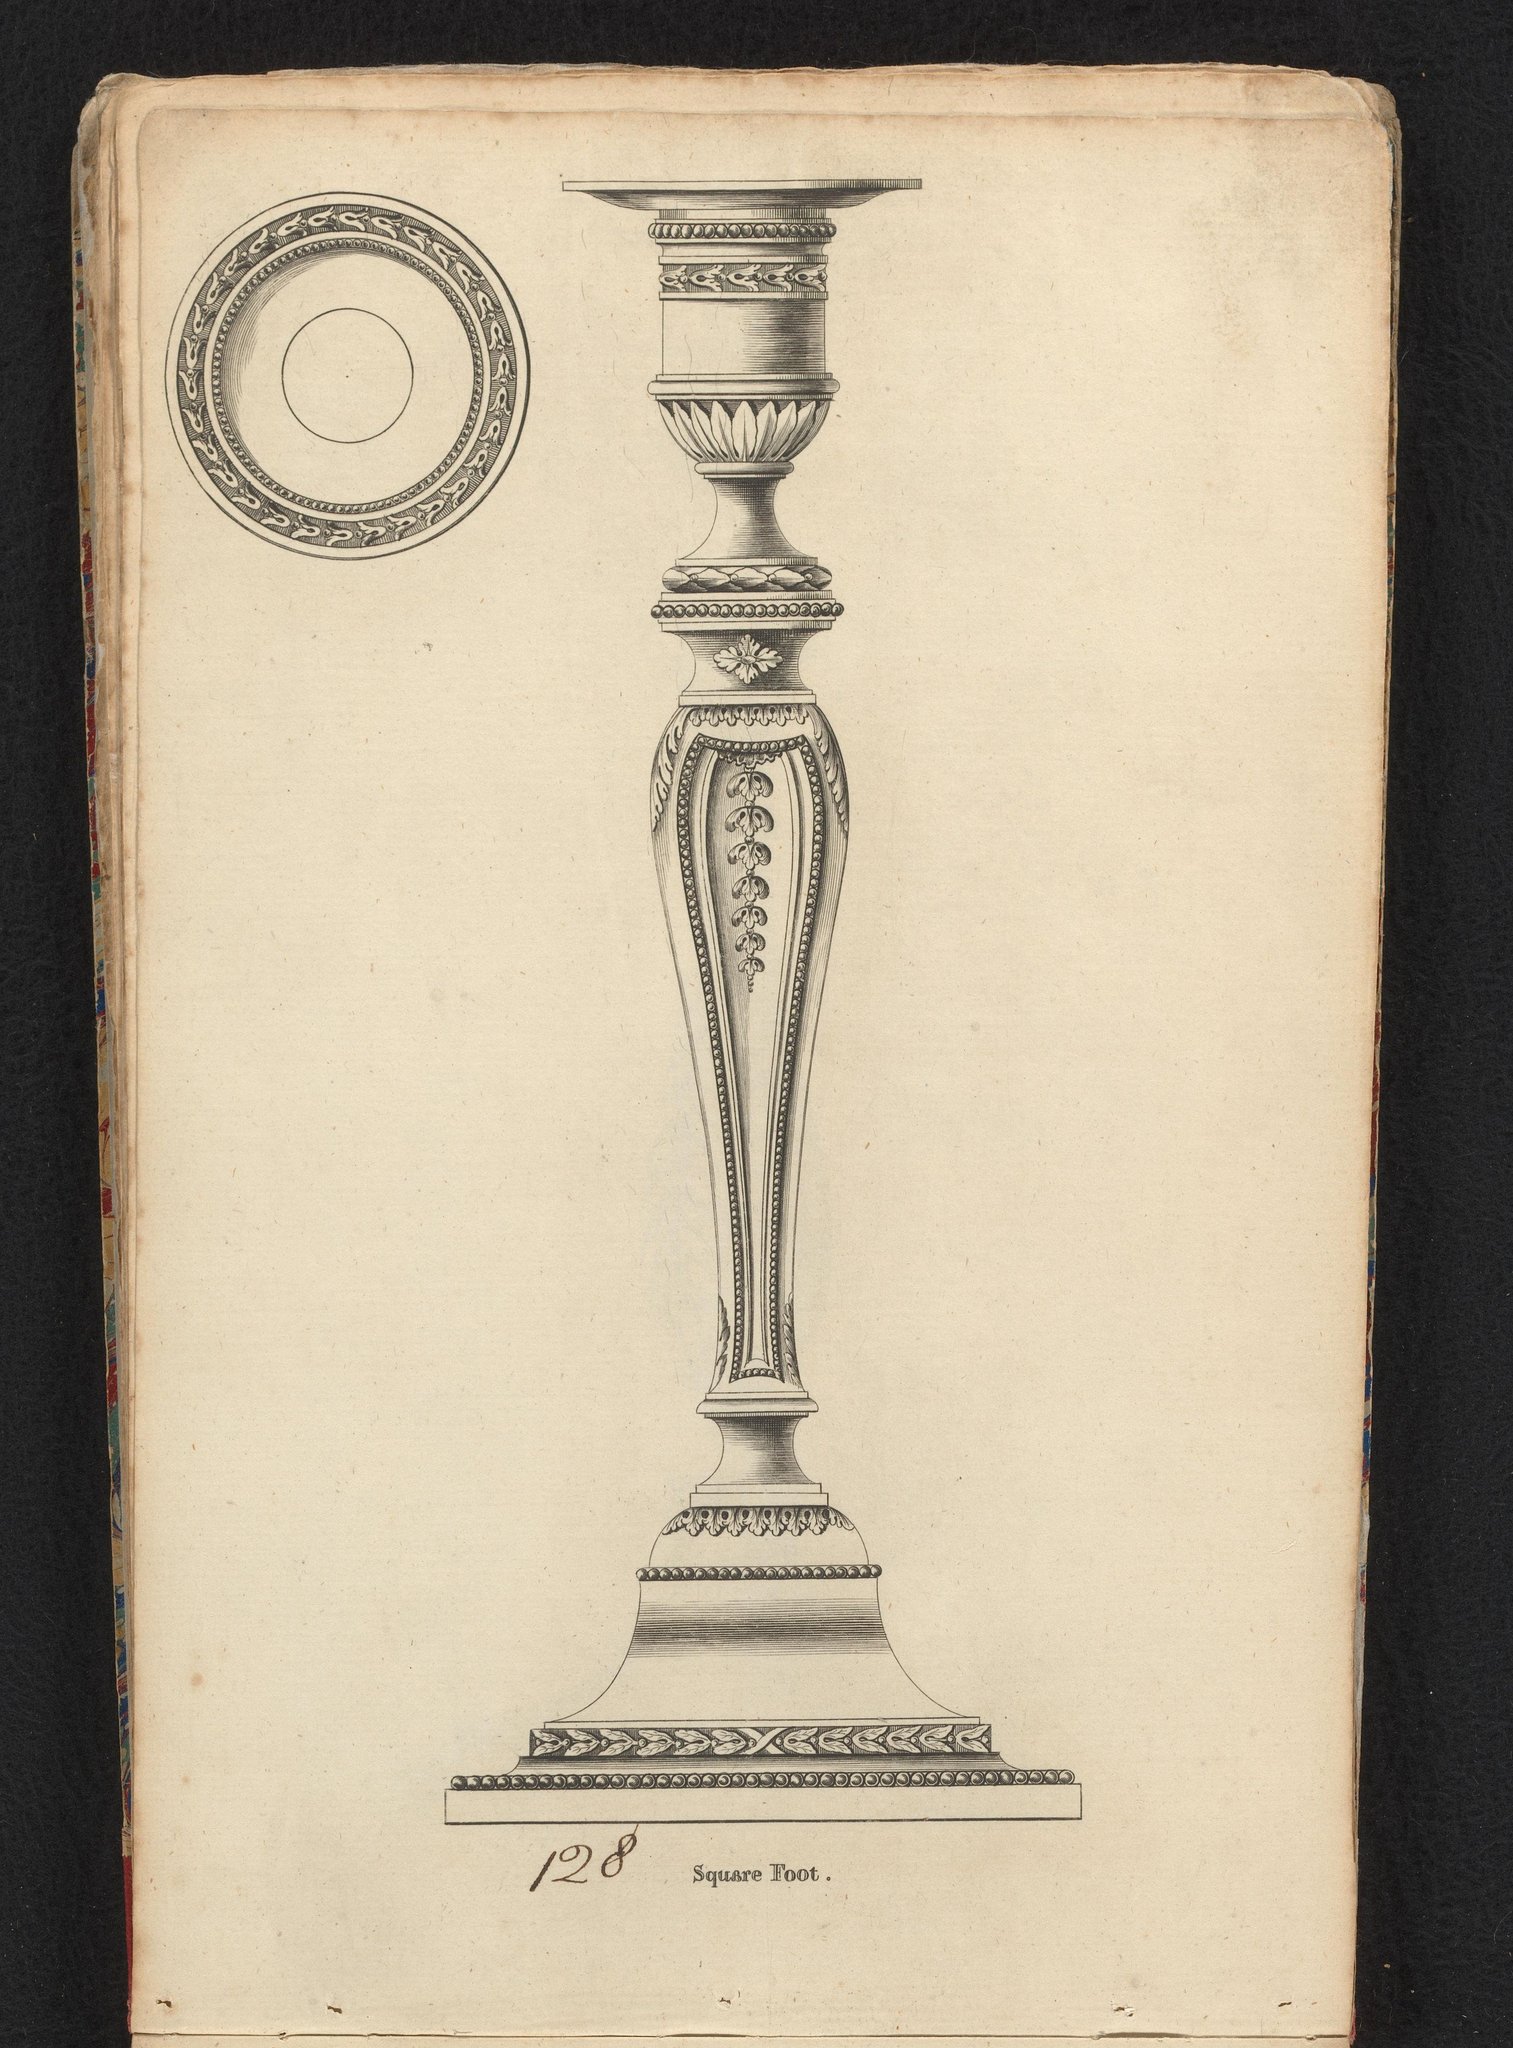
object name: ornament print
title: Ontwerp voor een kandelaar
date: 1784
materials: paper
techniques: engraving, etching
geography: england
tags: candlestick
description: Ontwerp voor een kandelaar met een vierkante voet, op het volle blad. Met detail van een ronde voet. Met gedrukt onderschrift en handgeschreven nr. 128. Onderdeel van een catalogus met assortiment modellen van Sheffield verzilverd vaatwerk (pleet) door Matthew Boulton.